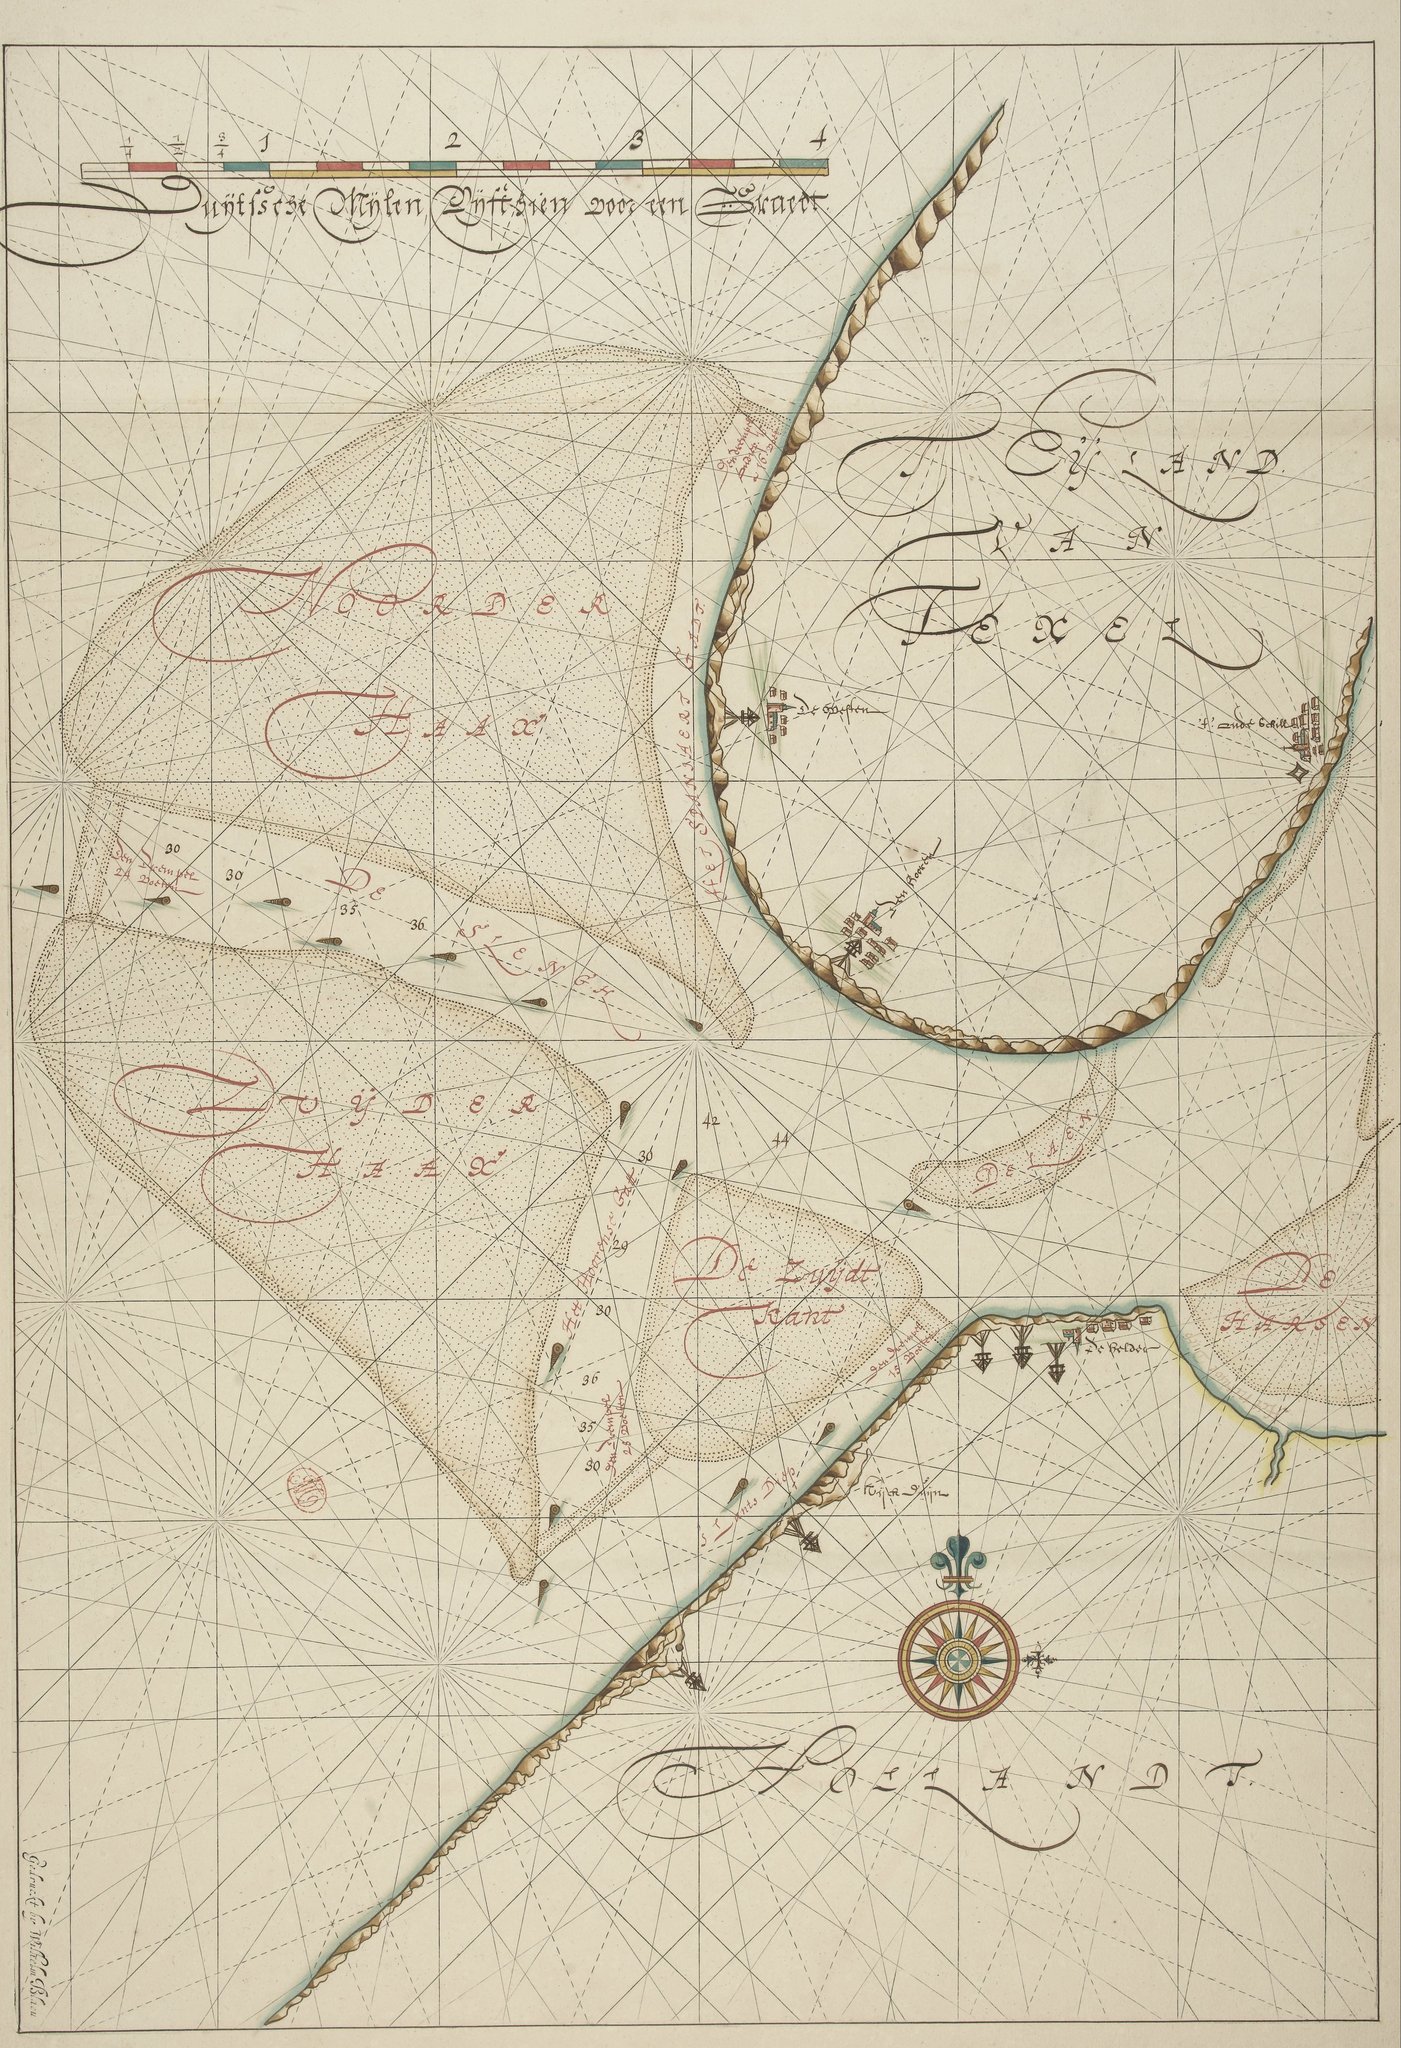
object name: print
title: Aanloop van Texel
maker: willem janszoon blaeu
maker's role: print maker, publisher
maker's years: 1571-1638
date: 1581-1638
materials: paper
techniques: engraving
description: Het eiland Texel rechtsboven; rechtsonder Holland.